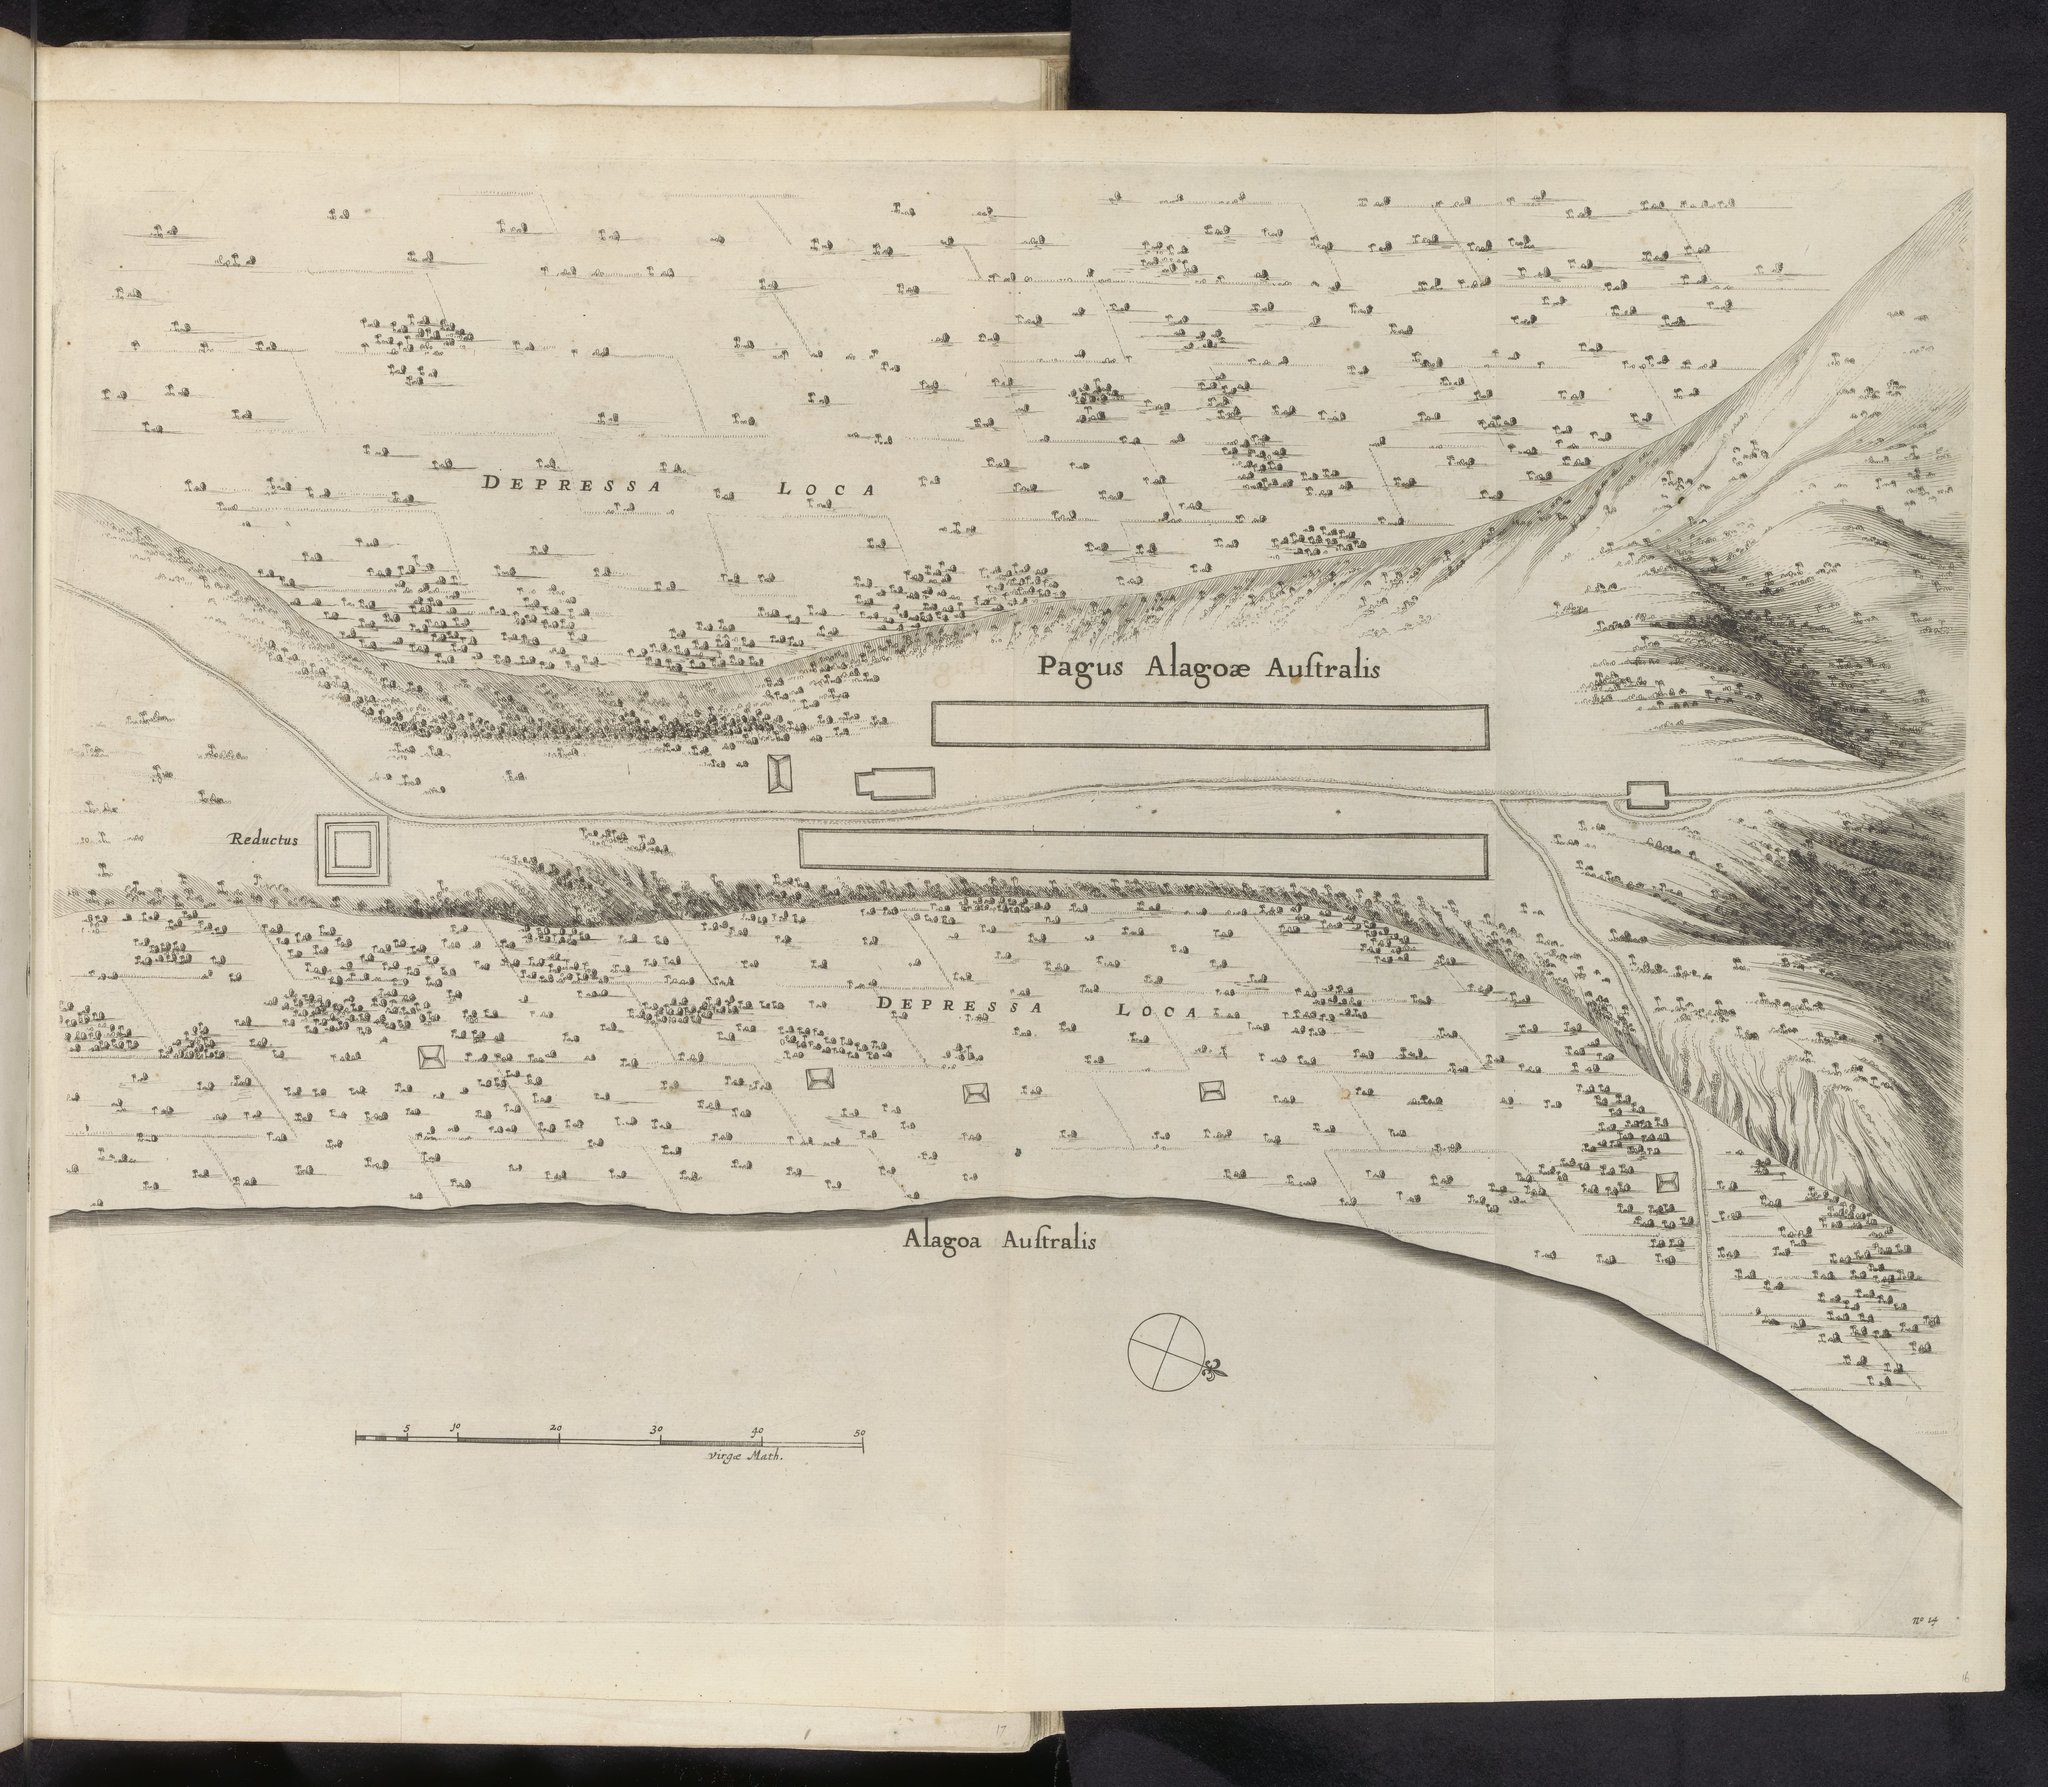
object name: map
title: Pagus Alagoae Australis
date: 1645-1647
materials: paper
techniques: engraving, etching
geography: amsterdam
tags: earl, johan maurits graaf van nassau-siegen, maps of cities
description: Illustratie in: Caspar Barlaeus, Rerum per octennium in Brasilia et alibi nuper gestarum sub praefectura J. Mauritii, Nassoviae, c. comitis... historia, Joannes Blaeu, Amsterdam 1647, plaat nr. 14, p. 40/41. Prent in het exemplaar in de collectie van de Rijksmuseum Research Library, standplaats 330 A 18.